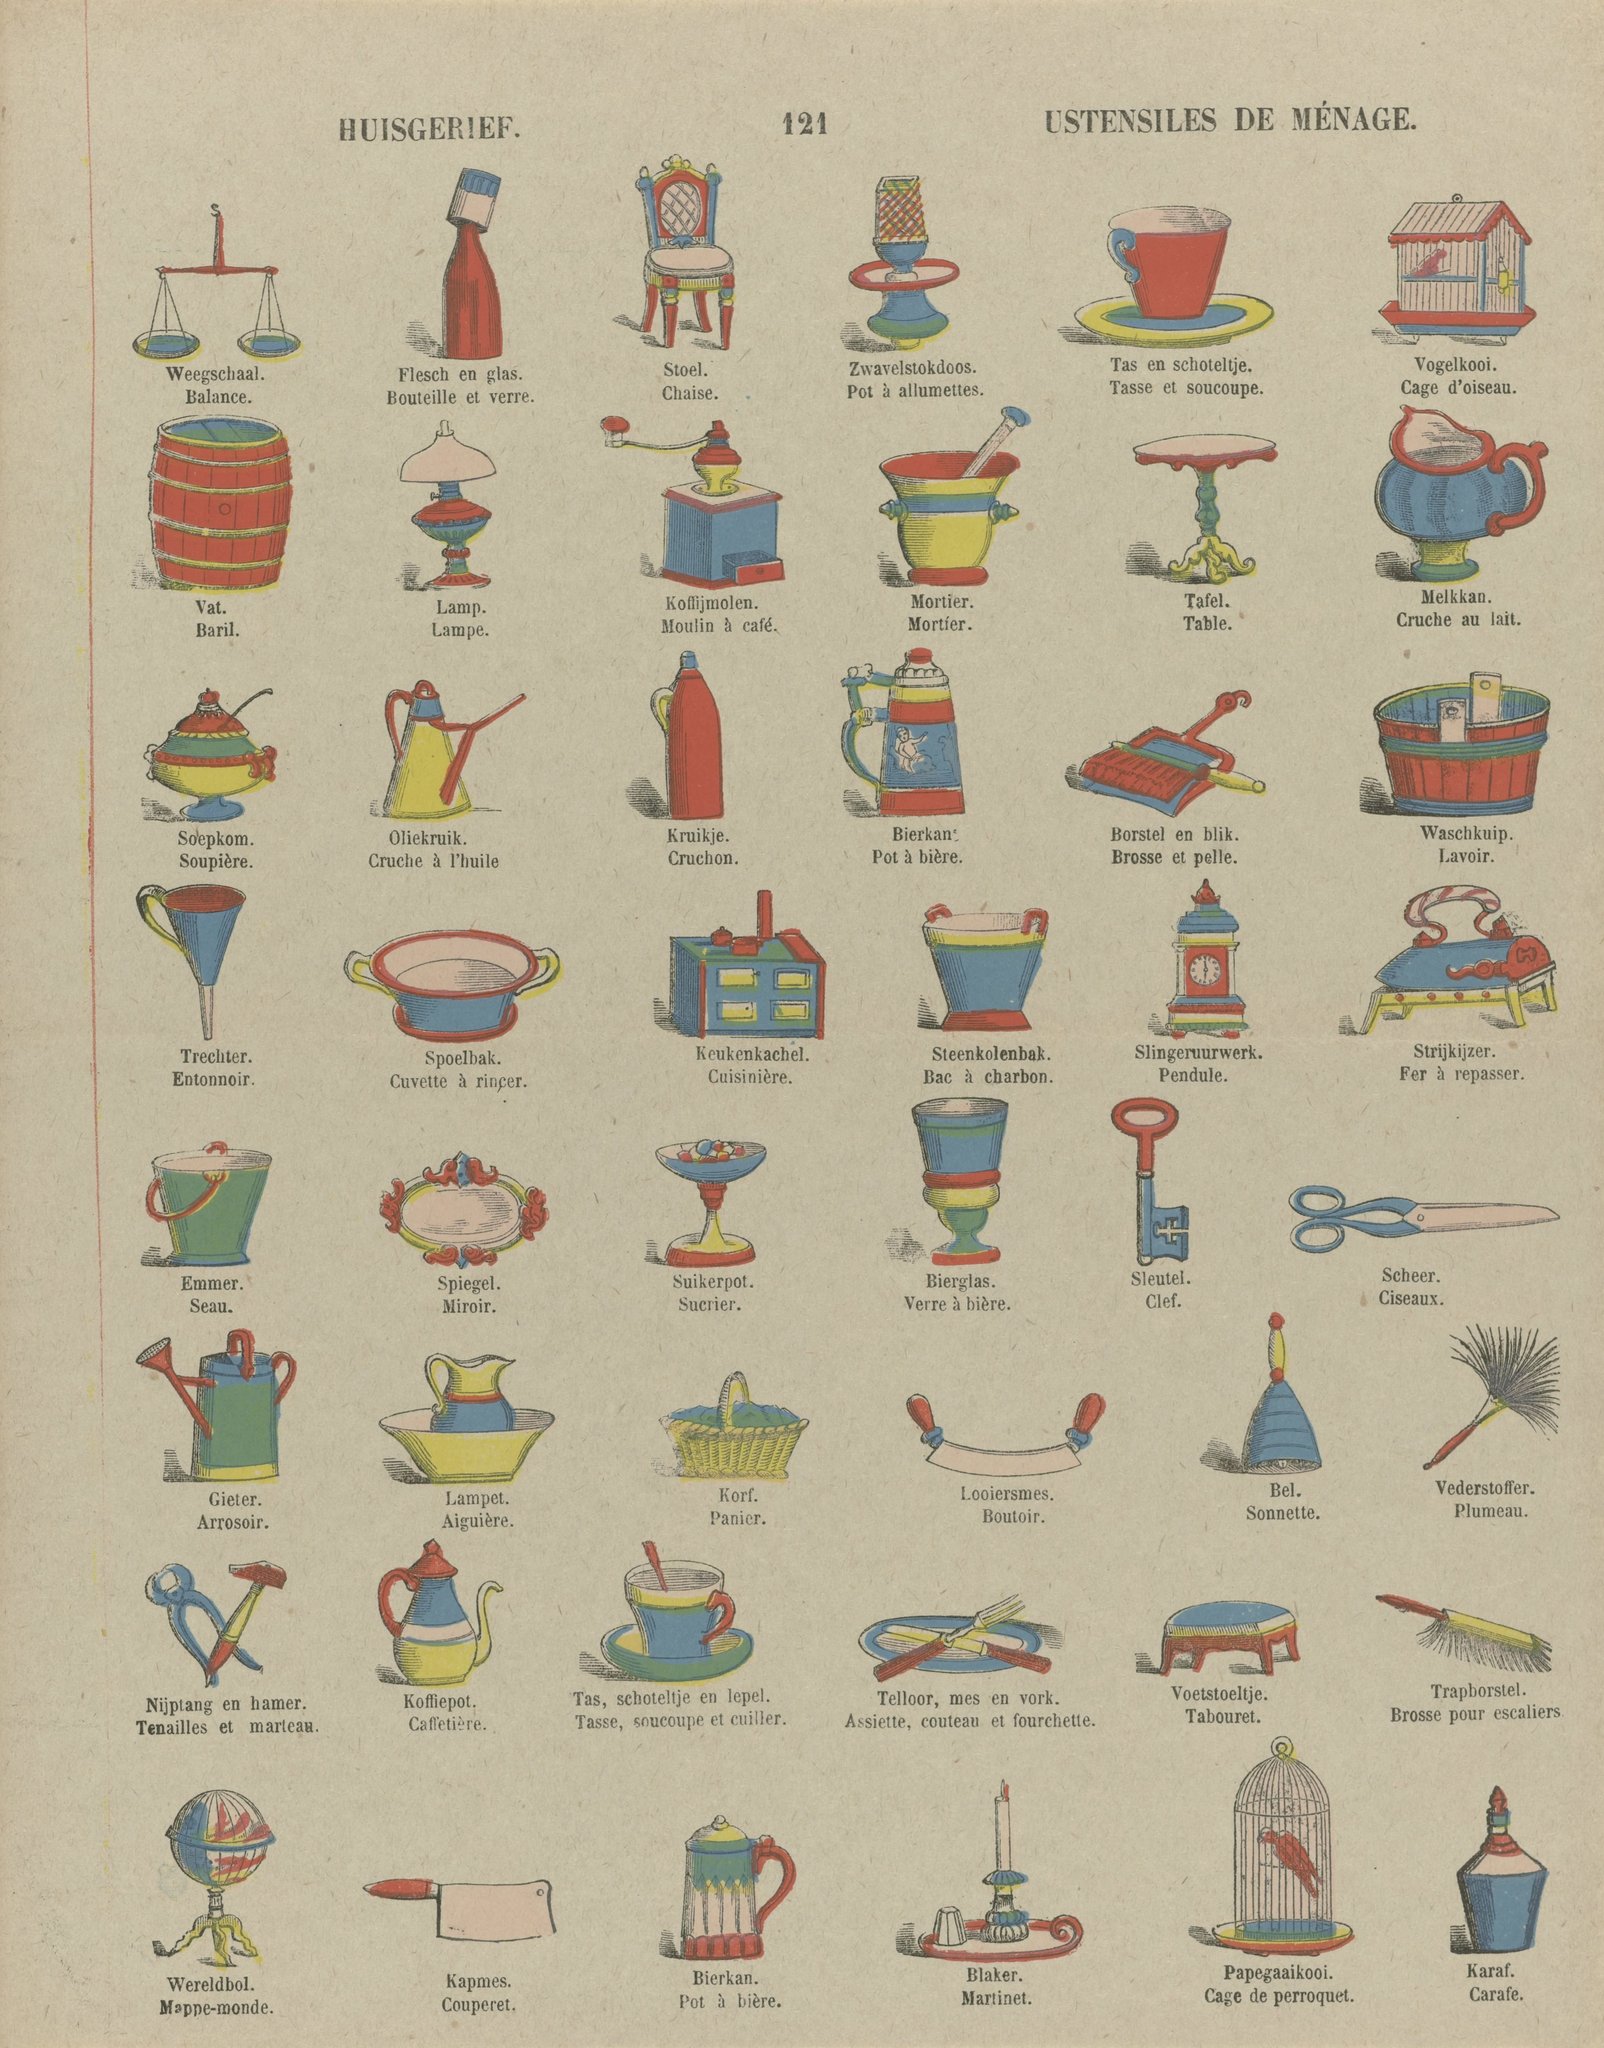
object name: print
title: Huisgerief / Ustensiles de ménage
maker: Anonymous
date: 1833-1911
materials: paper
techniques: lithograph, letterpress printing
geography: turnhout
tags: (household) utensils and implements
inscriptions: collector's mark: Lugt 2760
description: Blad met 48 voorstellingen van verschillende huishoudelijke voorwerpen. Onder elke voorstelling een onderschrift in het Nederlands en in het Frans. Genummerd midden boven: 121.